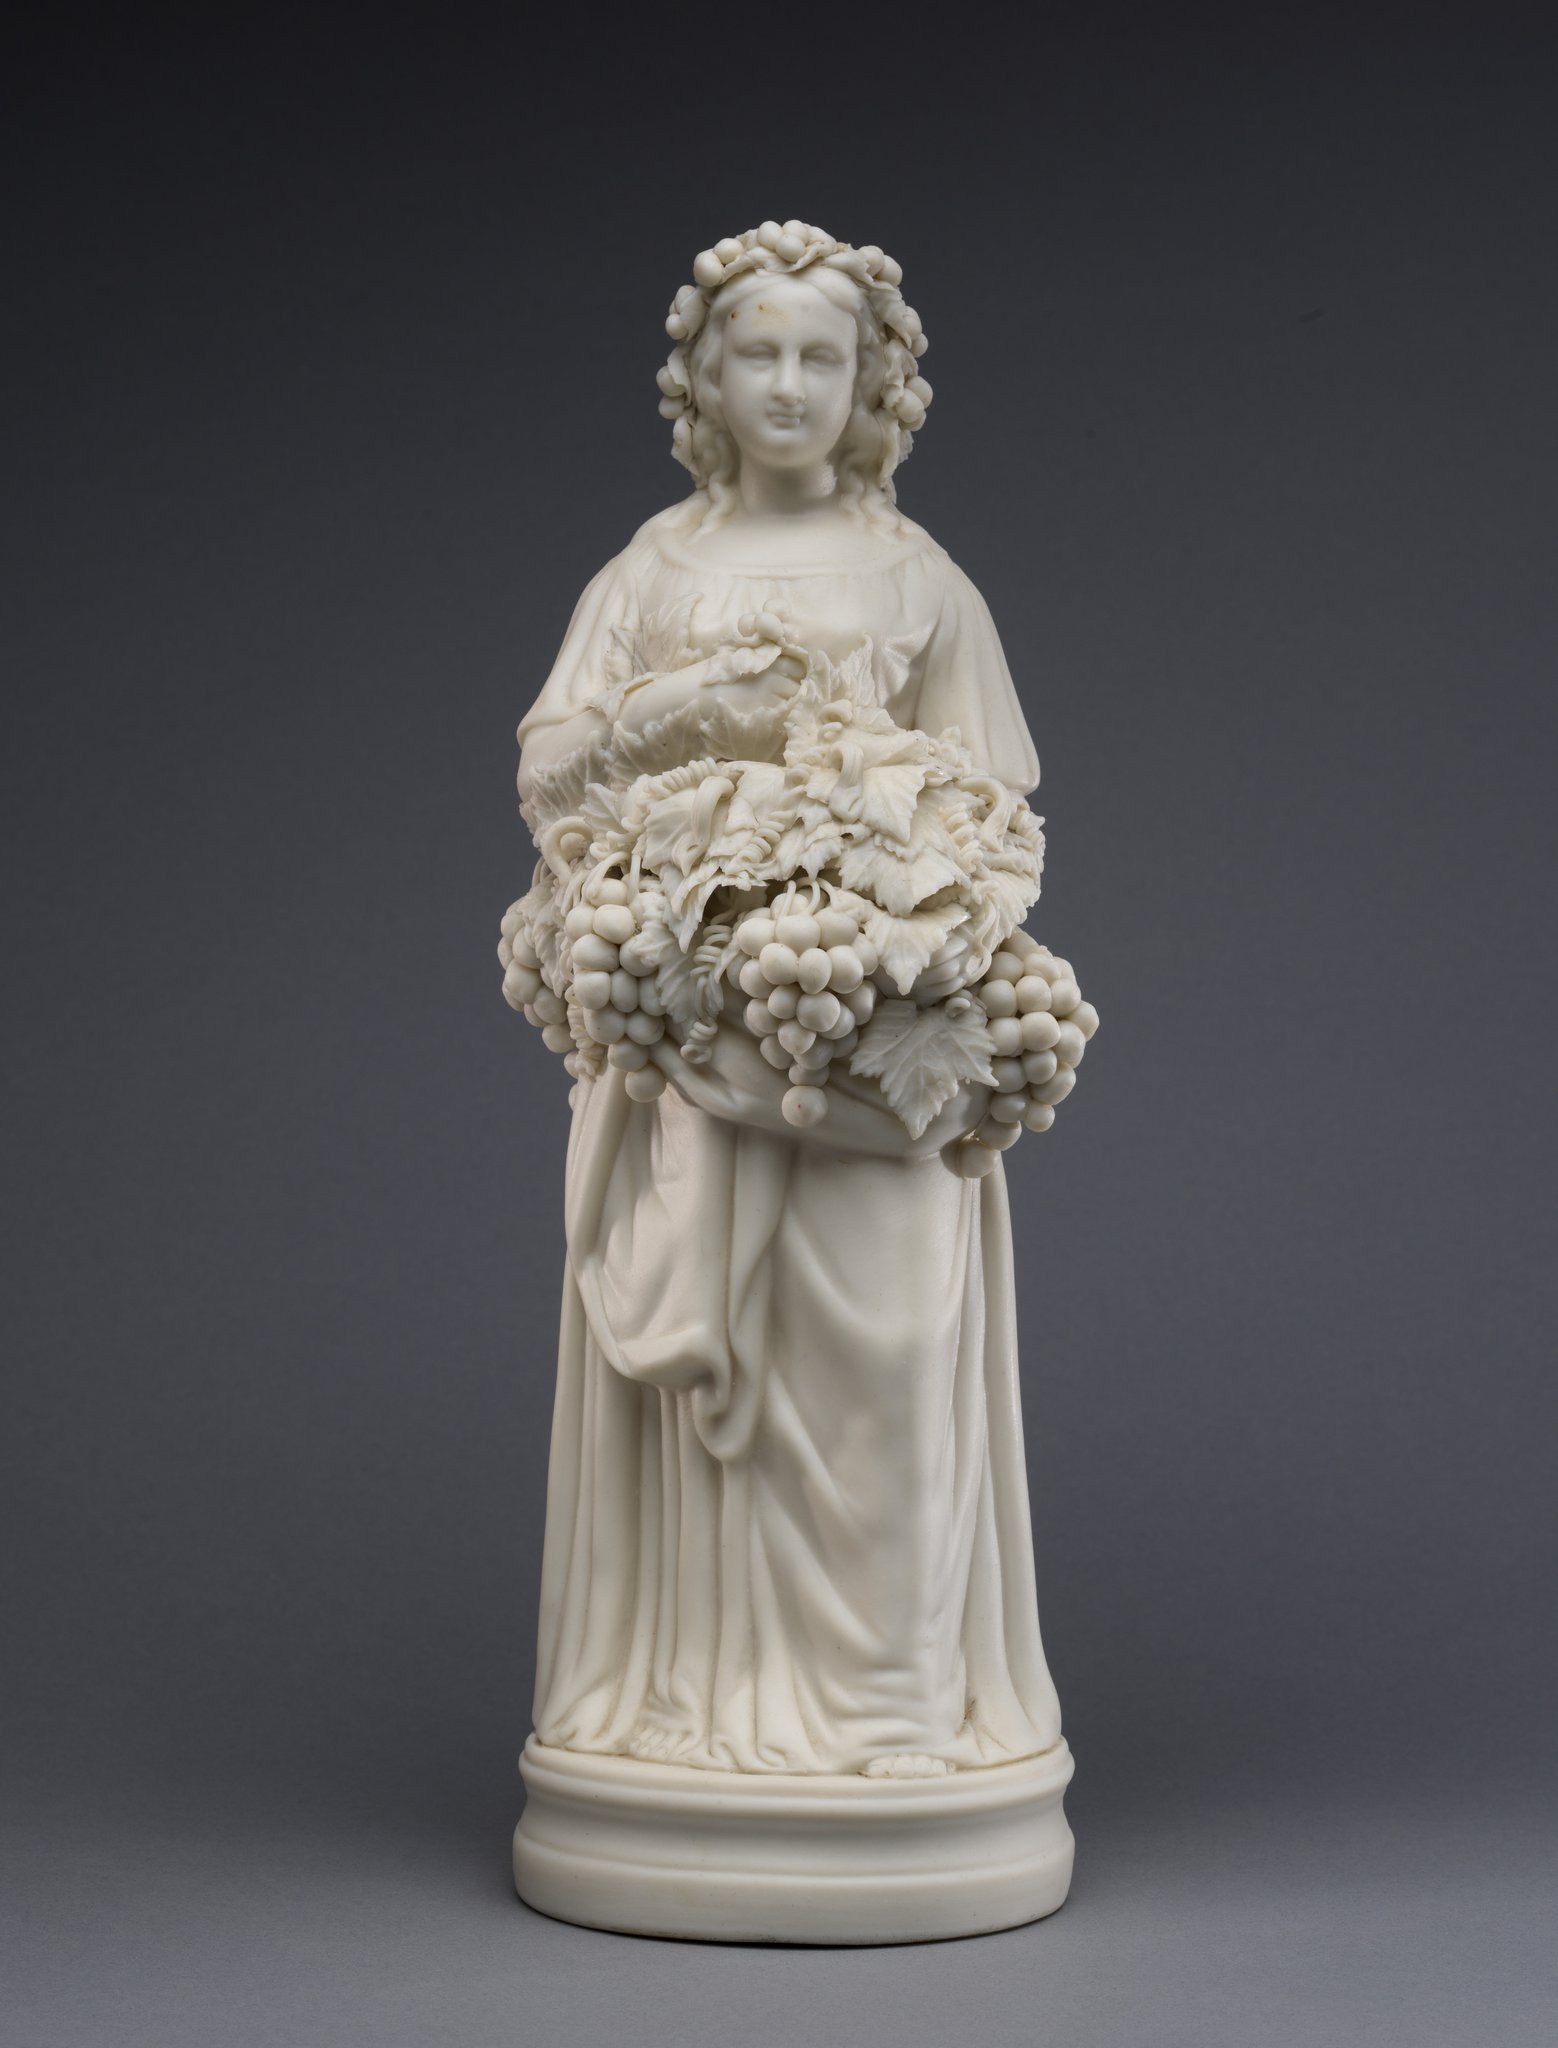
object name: figure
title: Figure of Autumn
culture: american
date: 1830-1870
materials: porcelain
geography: united states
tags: grapes,women